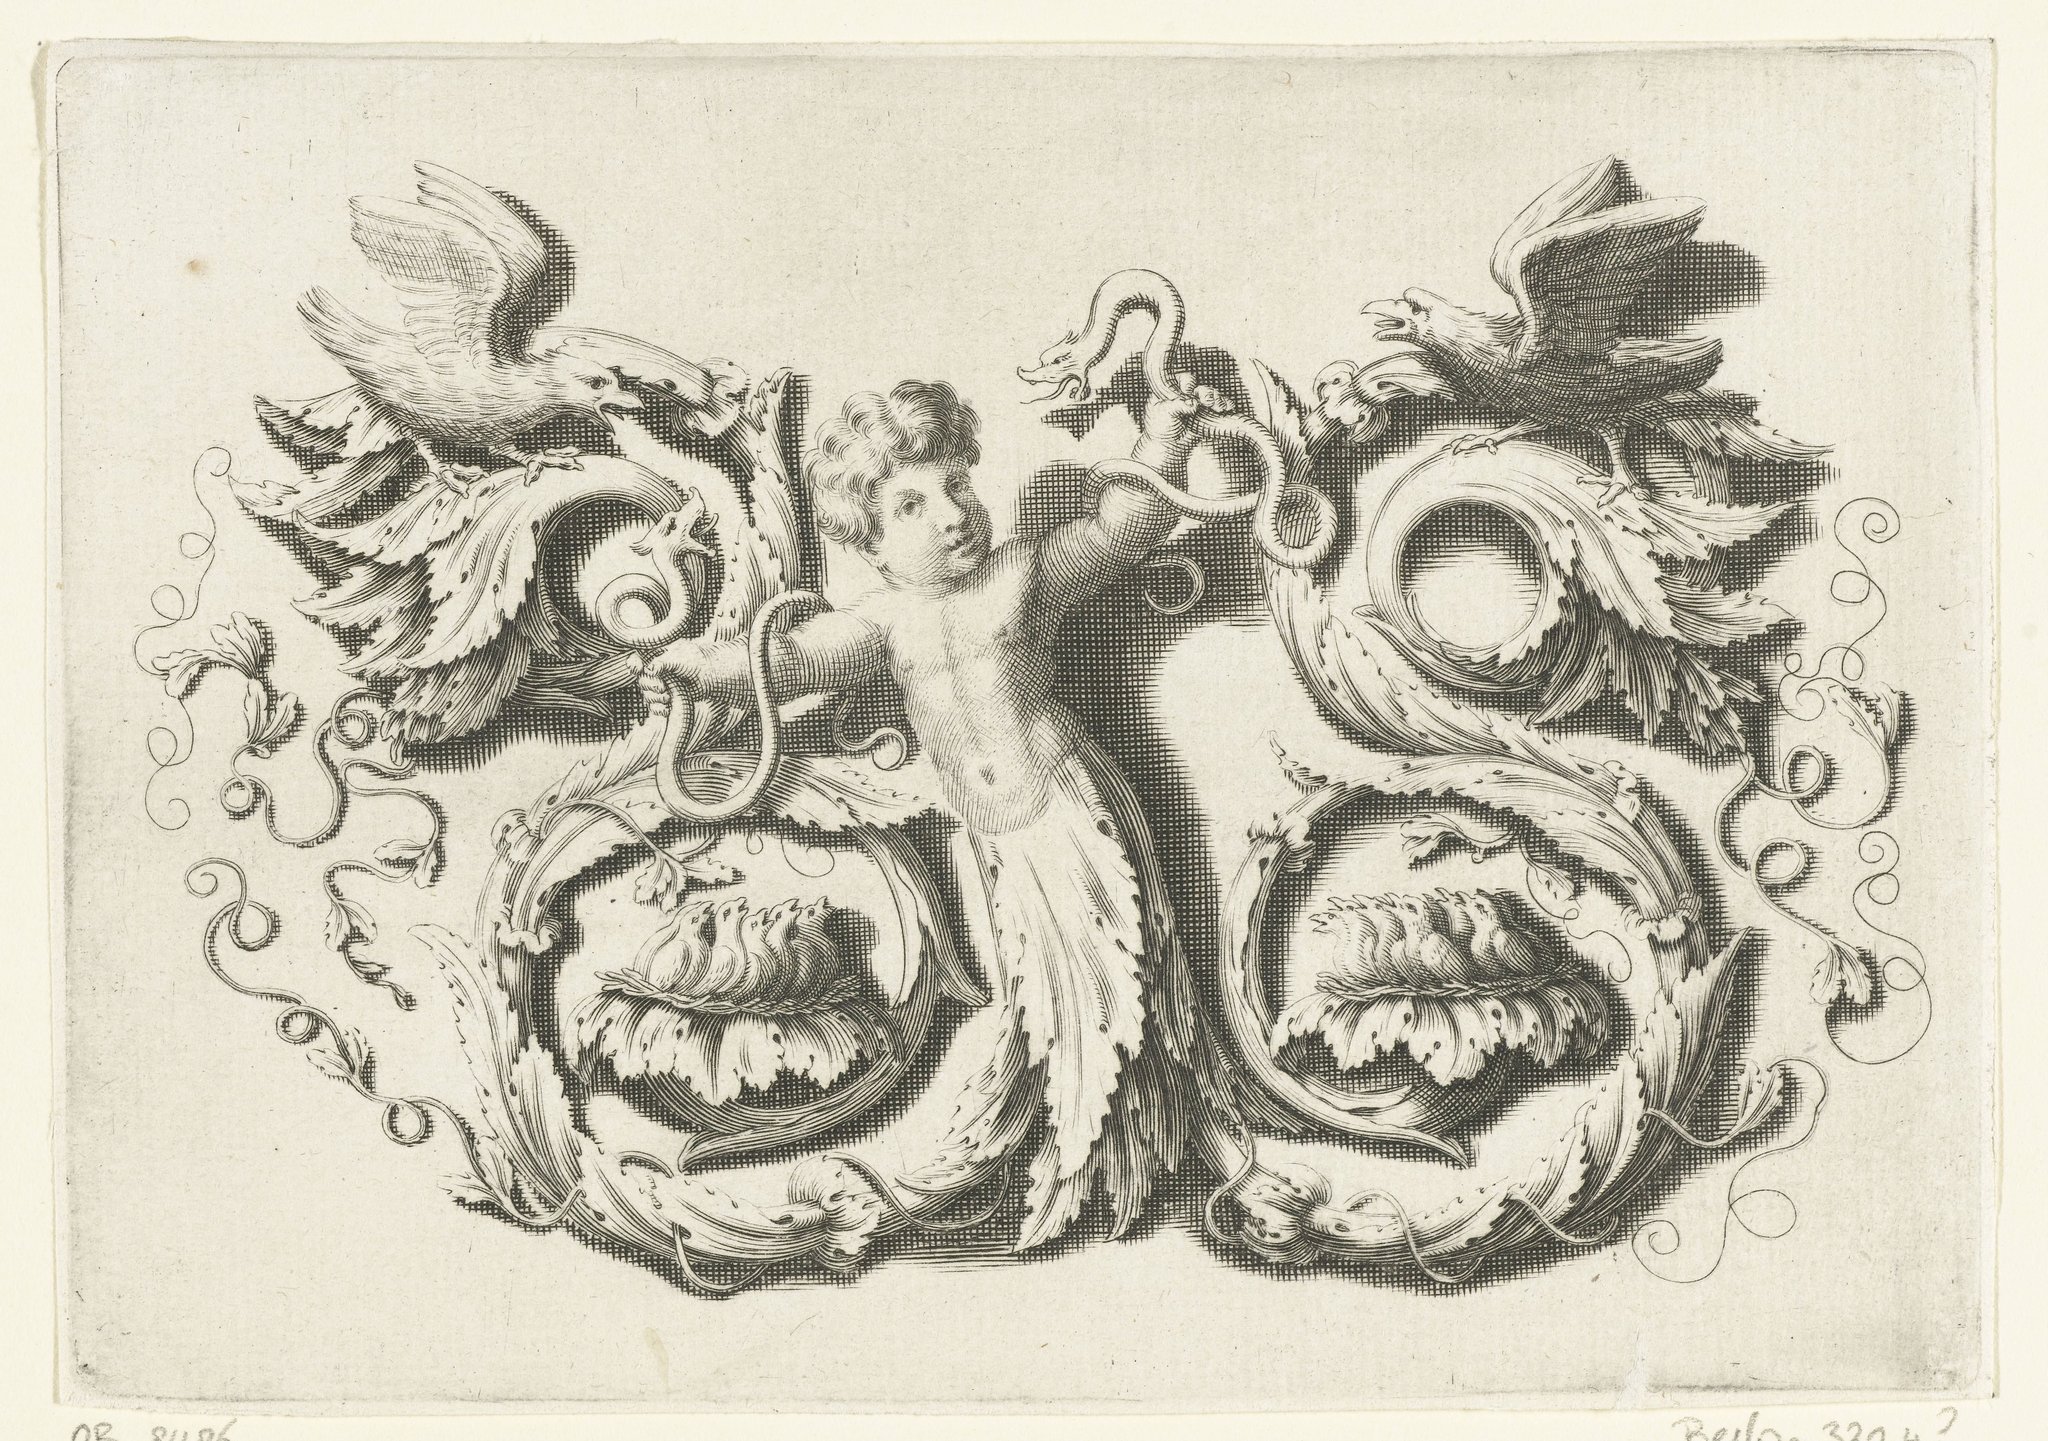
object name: ornament print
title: Kind met onderlijf van bladranken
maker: Anonymous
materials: paper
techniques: engraving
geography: paris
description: Vignet. Elke bladrank eindigt in een vogelnest, bovenaan pikken vogels naar twee slangen die het kind vast heeft.